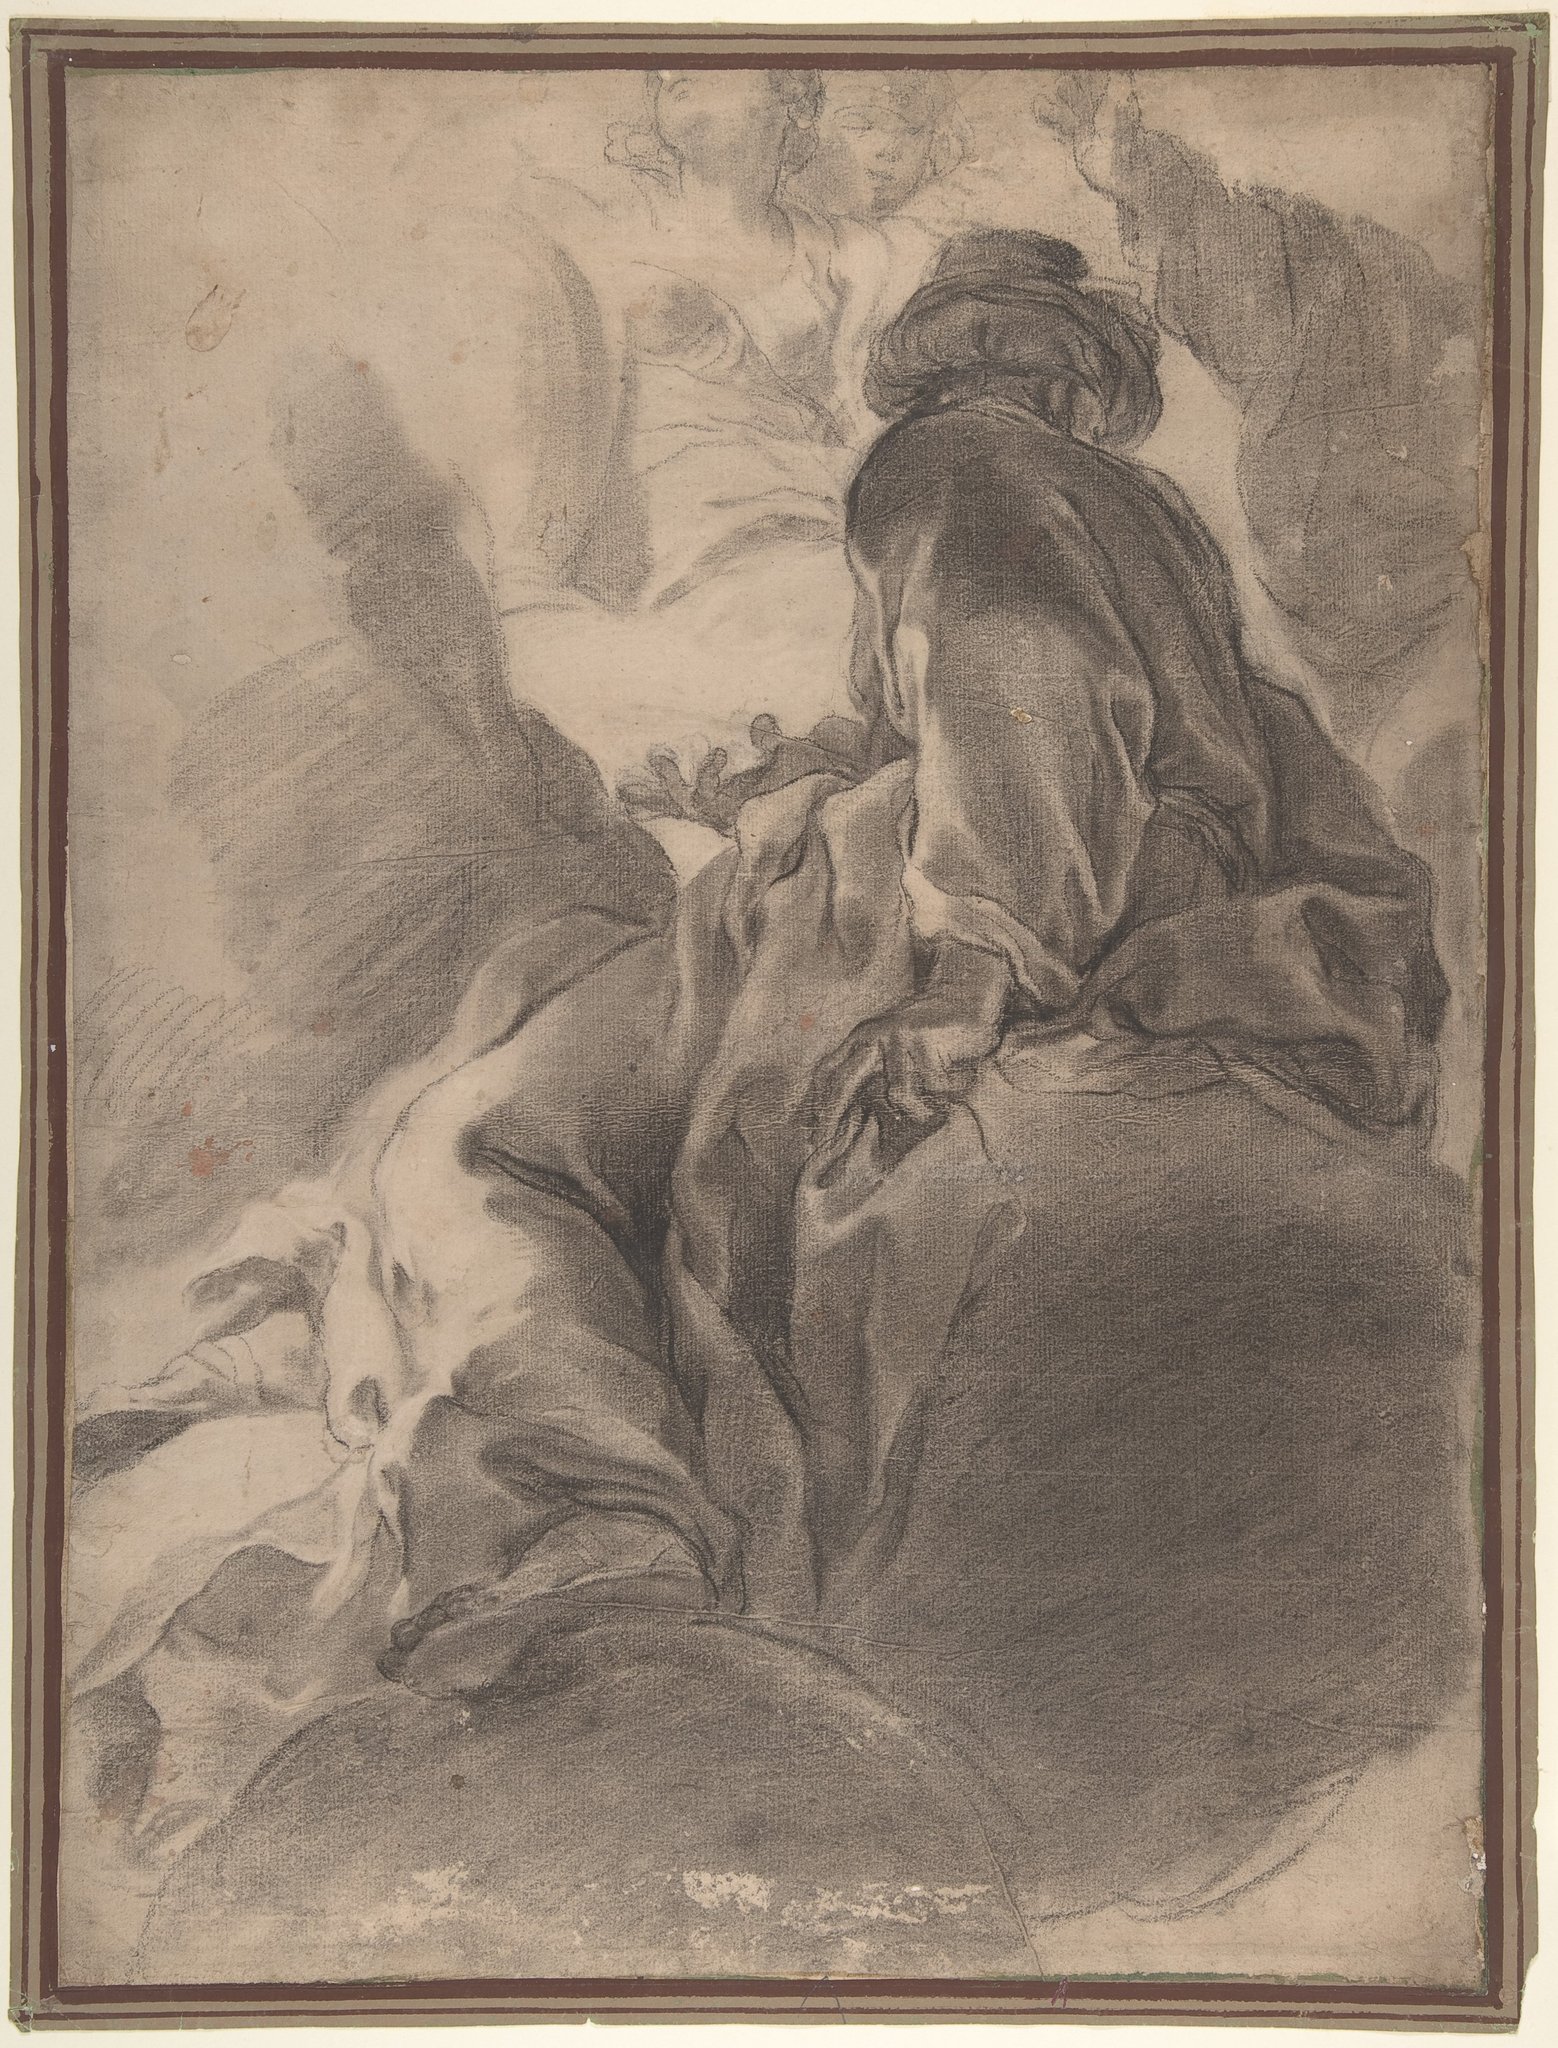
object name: drawing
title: Seated Prophet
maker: gaetano gandolfi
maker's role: artist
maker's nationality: italian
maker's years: 1734-1802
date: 1779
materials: chalk, paper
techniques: brush, highlighting, stumping, wash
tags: men